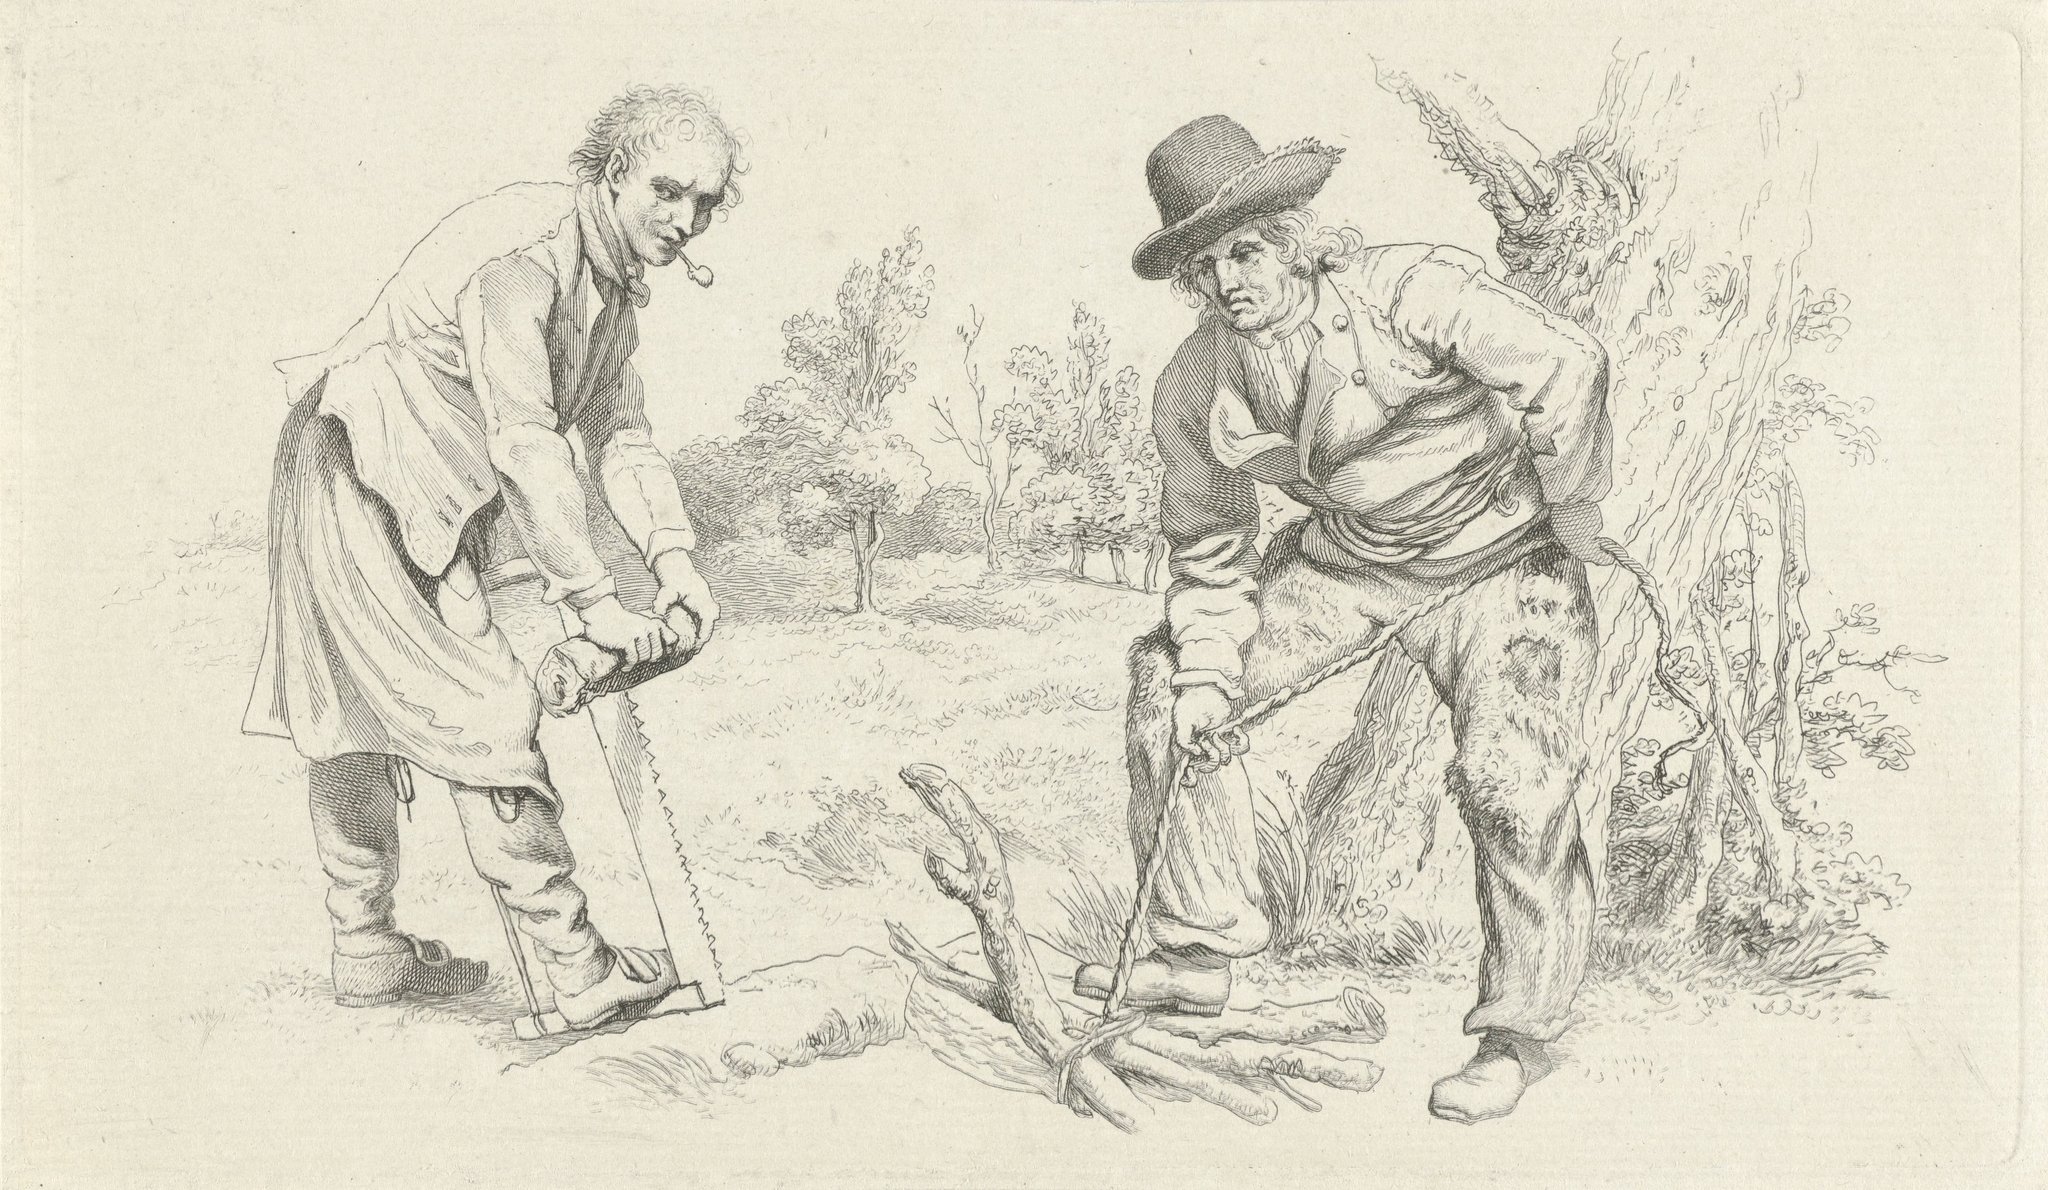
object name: print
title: Studieblad met een houtsprokkelaar en een man met zaag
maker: jacob ernst marcus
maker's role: draughtsman, print maker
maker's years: 1774-1826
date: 1808-1809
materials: paper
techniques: etching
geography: amsterdam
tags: forest worker, woodgathering, woodgatherer, tools, aids, implements ~ crafts and industries: saw, tools, aids, implements ~ crafts and industries: rope, sawing (industrial process)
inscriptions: collector's mark: Lugt 2228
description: Serie voor het eerst uitgegeven door Jacob Ernst Marcus onder de titel Studiebeelden en Fragmenten. Amsterdam: ca.1816. Later heruitgegeven als: Studie-prentwerk/ Etudes gravées.